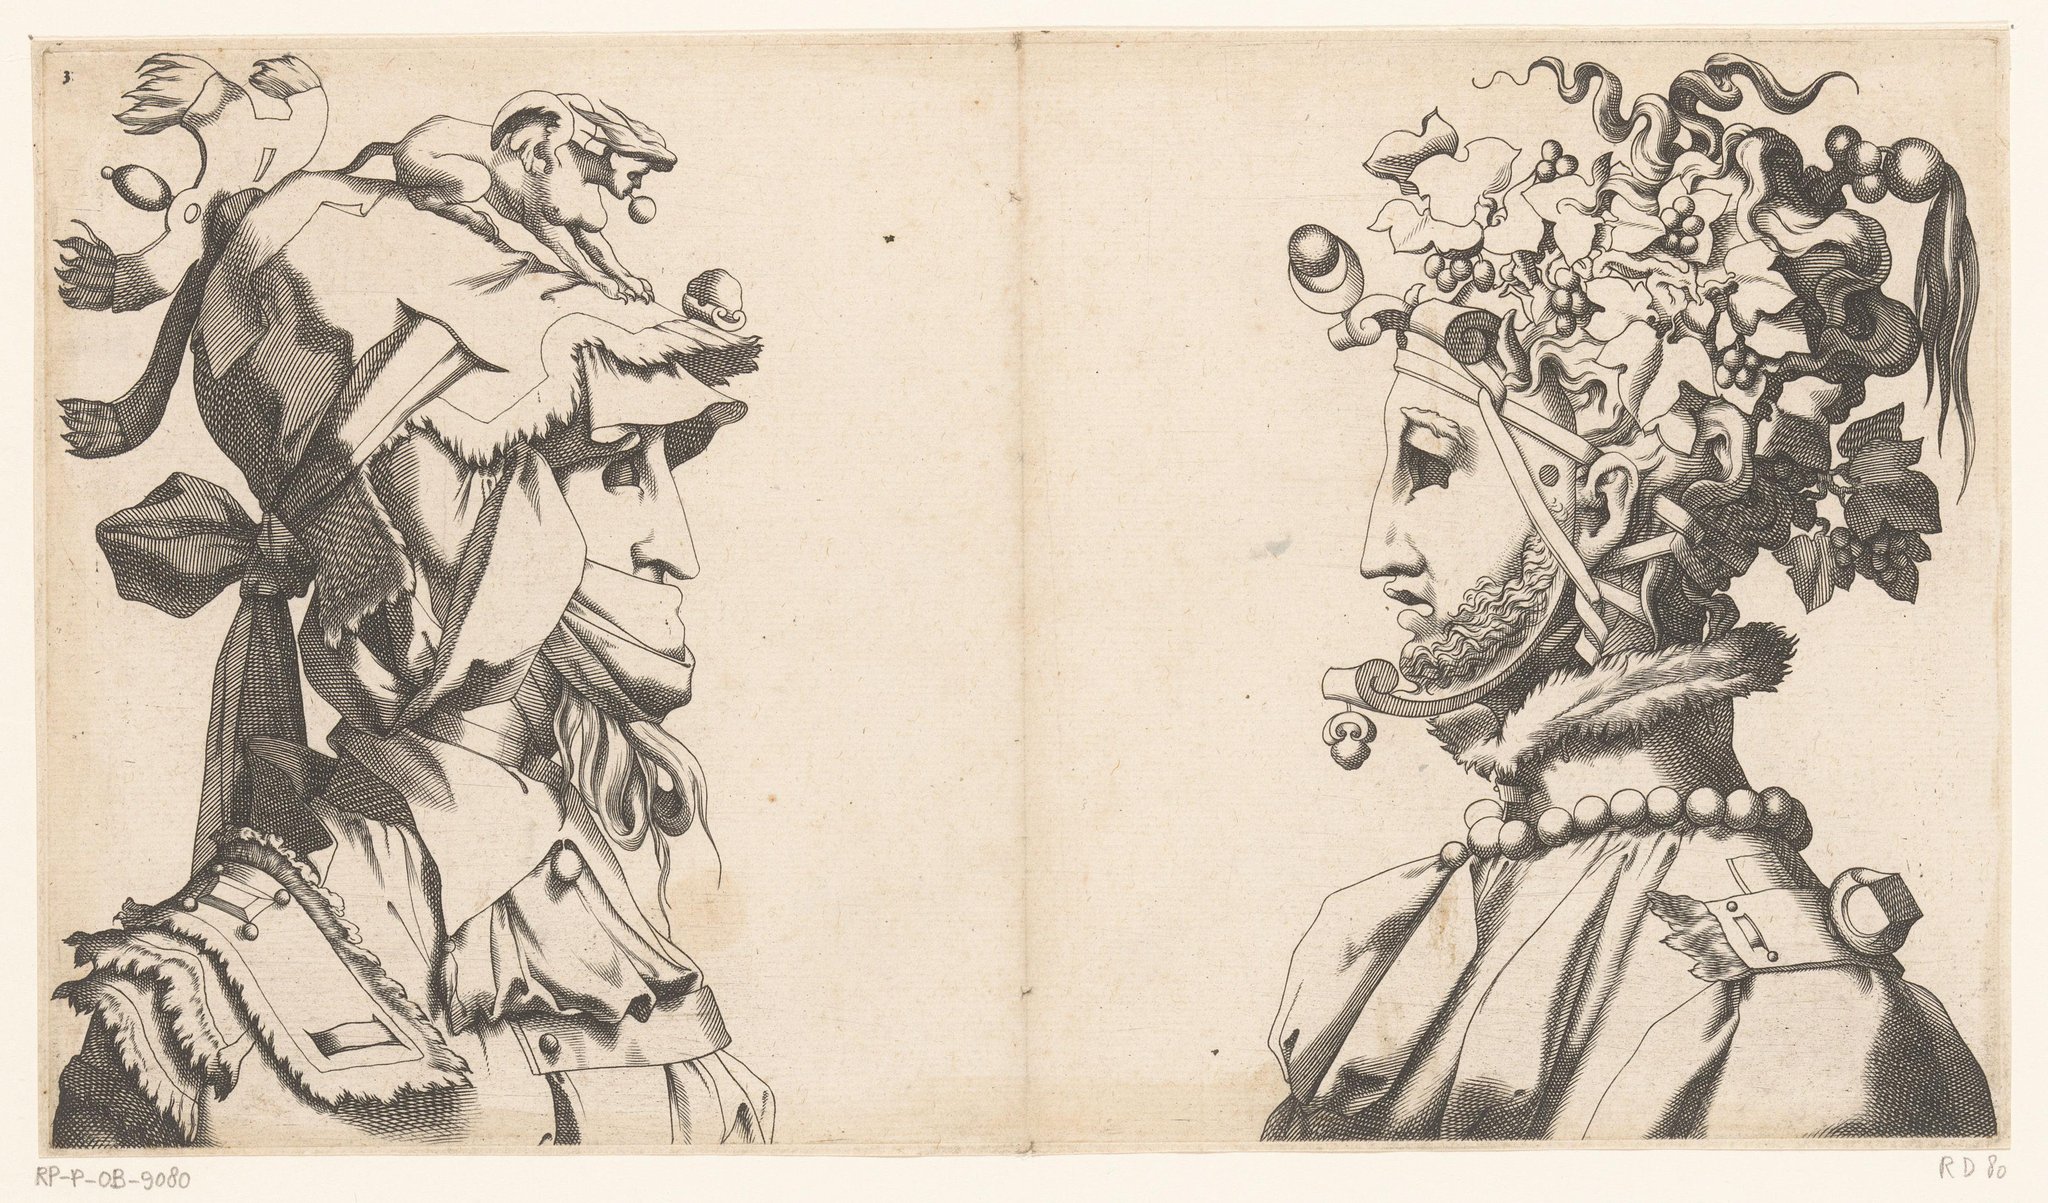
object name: print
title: Coiffures ou masques d'hommes et de femmes pour des ballets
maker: rené boyvin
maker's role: print maker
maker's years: 1525-1598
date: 1535-1598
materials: paper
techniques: engraving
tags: mask, head-gear, the arts of the stage: ballet, theatre, musical drama, motion picture, fantasy costume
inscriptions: collector's mark: Lugt 240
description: Maakt deel uit van een serie van twaalf prenten met mannen- en vrouwenkostuums en haardrachten voor het ballet, getiteld 'Coiffures ou masques d'hommes et de femmes pour des ballets', naar ontwerp door Rosso Fiorentino. Bij de tweede staat zijn de platen van zowel de mannen als de vrouwen 1 t/m 6 genummerd.